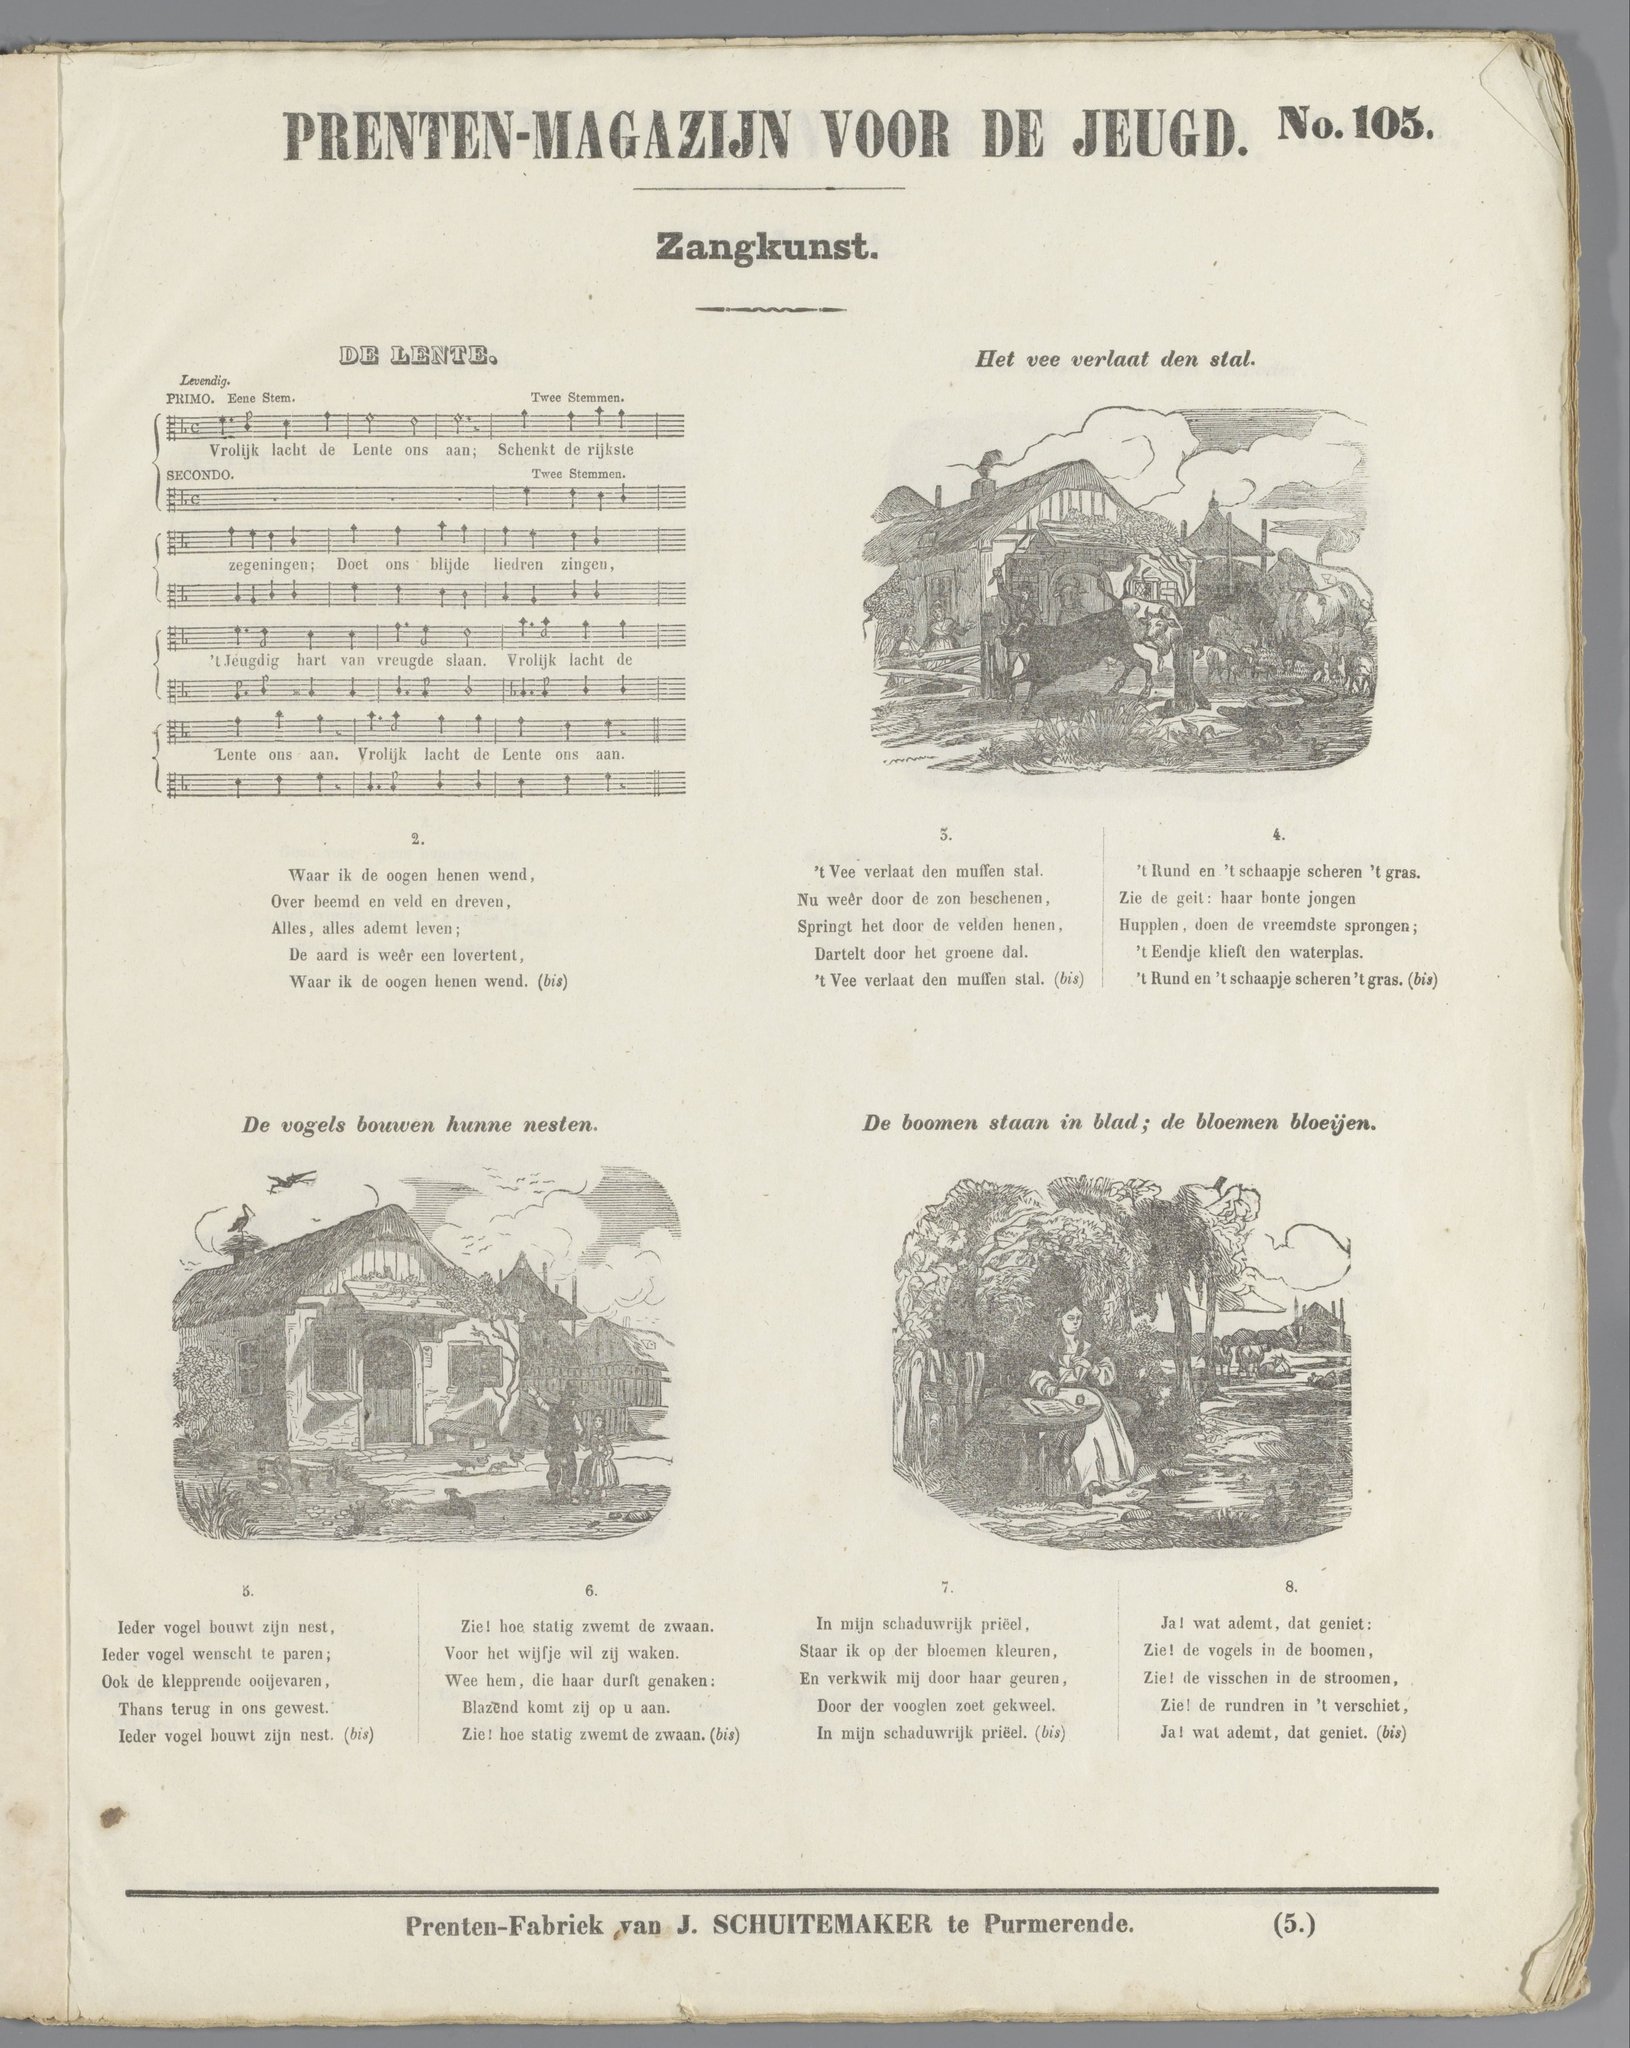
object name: print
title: Groot en goed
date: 1853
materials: paper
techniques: letterpress printing, engraving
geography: netherlands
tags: spring ~ human activities (the four seasons of the year), printed edition of musical score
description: Blad met muziekstuk 'De Lente' en 3 voorstellingen: het vee verlaat de stal, de vogels bouwen nesten en bomen staan in blad en de bloemen bloeien. Onder de voorstellingen diverse coupletten van het muziekstuk. Genummerd rechtsboven: No. 105, linksonder: (5.).